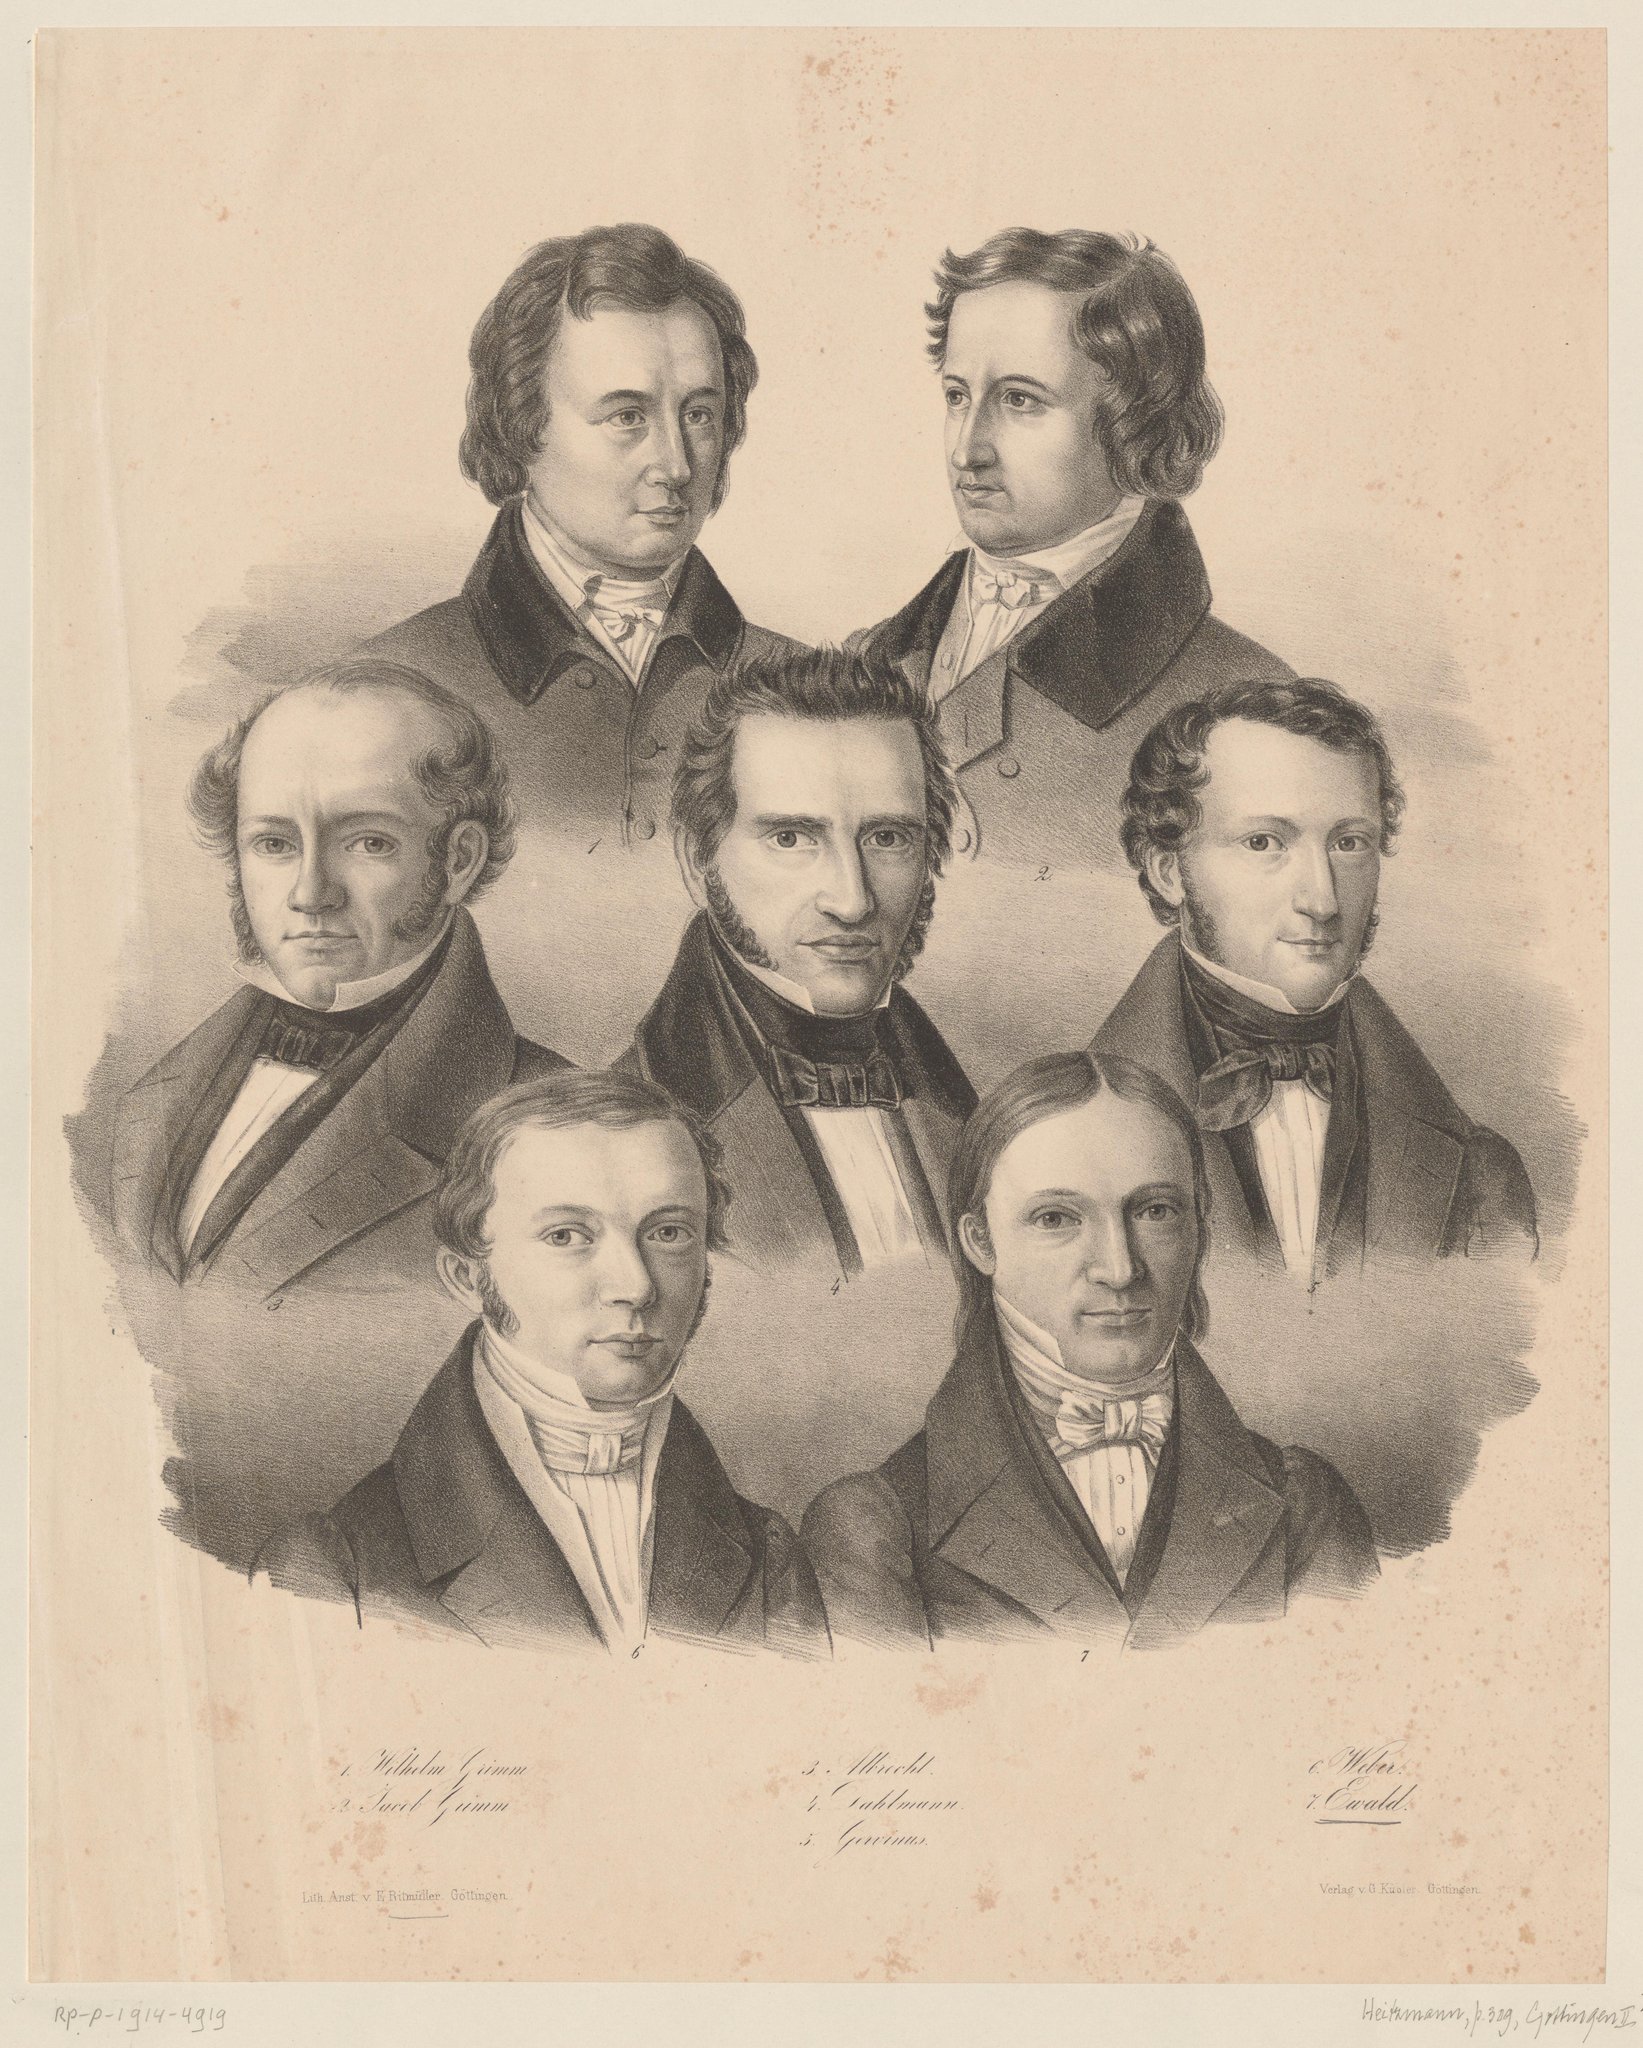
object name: print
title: Portretten van de Göttinger Sieben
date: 1837-1839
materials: paper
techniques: lithograph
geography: gottingen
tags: berlin, jacob ludwig karl grimm, politician, historical persons, portrait of a writer, politician, e.g. party leader, professor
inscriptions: collector's mark: Lugt 2228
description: De portretten zijn genummerd 1 tot en met 7. Vanwege hun protest tegen het opheffen van de vrijzinnige grondwet in 1837 werden de Göttinger Sieben ontslagen of verbannen.